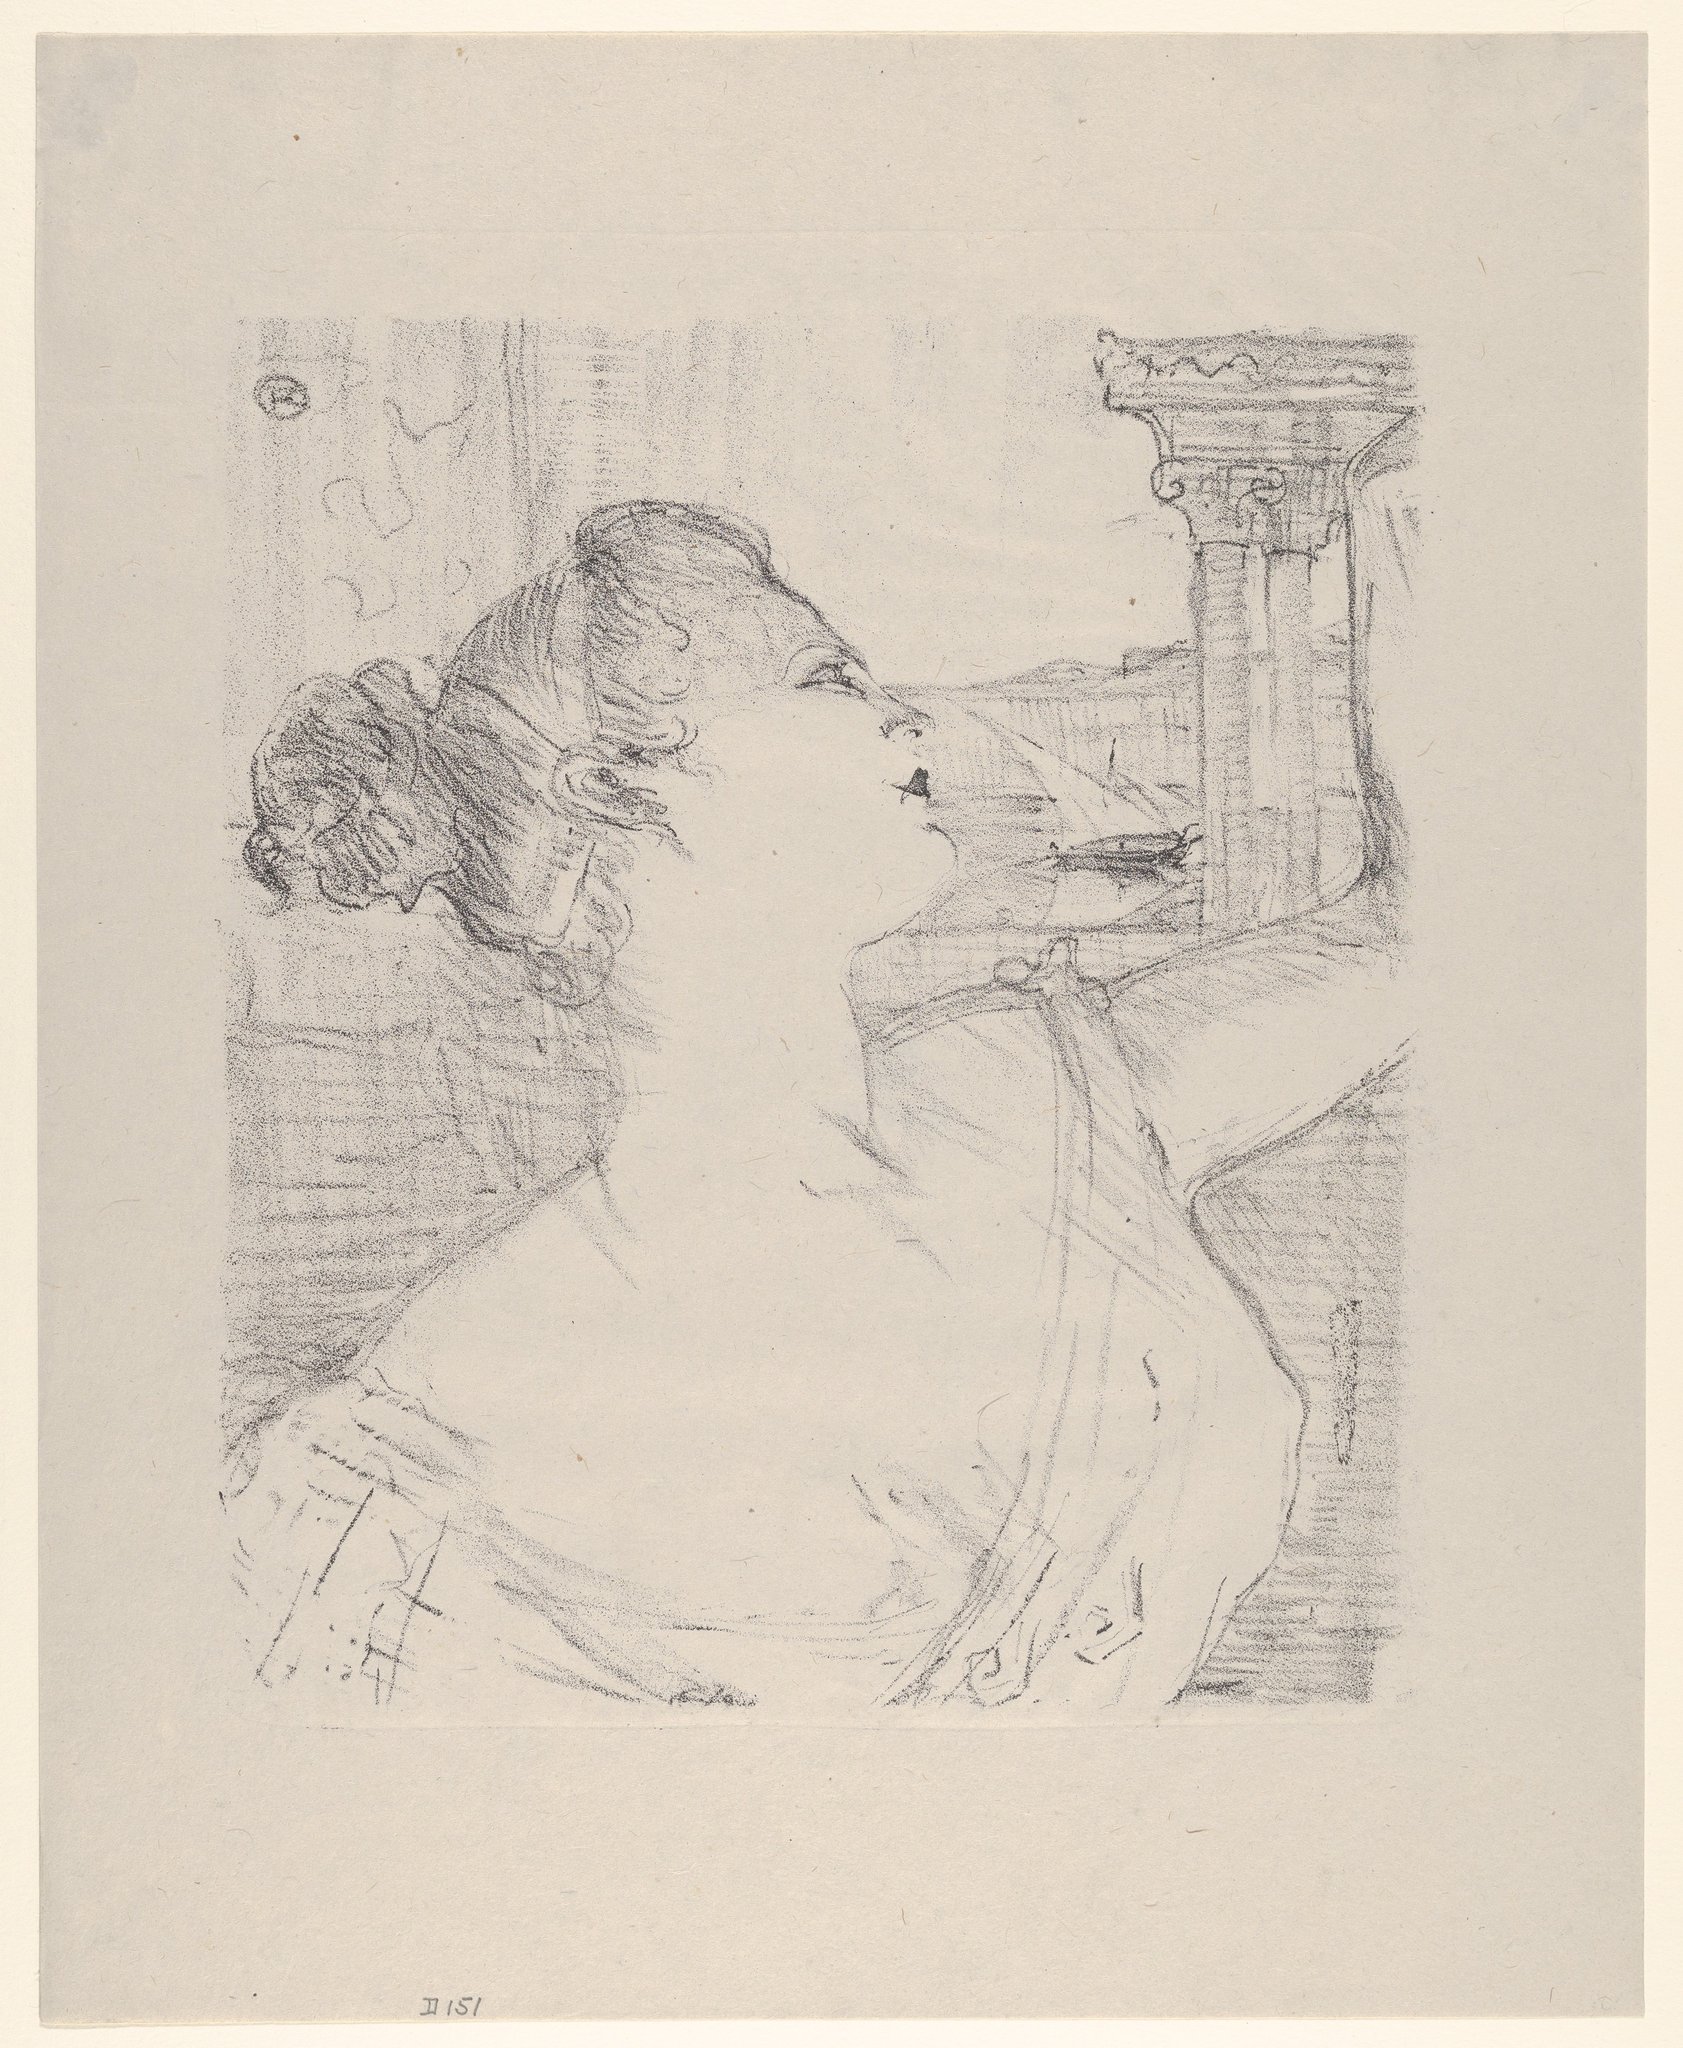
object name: print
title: Sybil Sanderson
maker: henri de toulouse-lautrec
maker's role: artist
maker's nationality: french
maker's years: 1864-1901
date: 1898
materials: paper, crayon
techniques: lithograph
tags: women